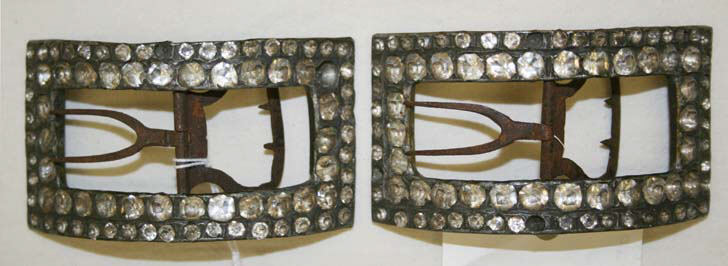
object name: shoe buckle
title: Shoe buckles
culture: european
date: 1667-1700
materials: copper